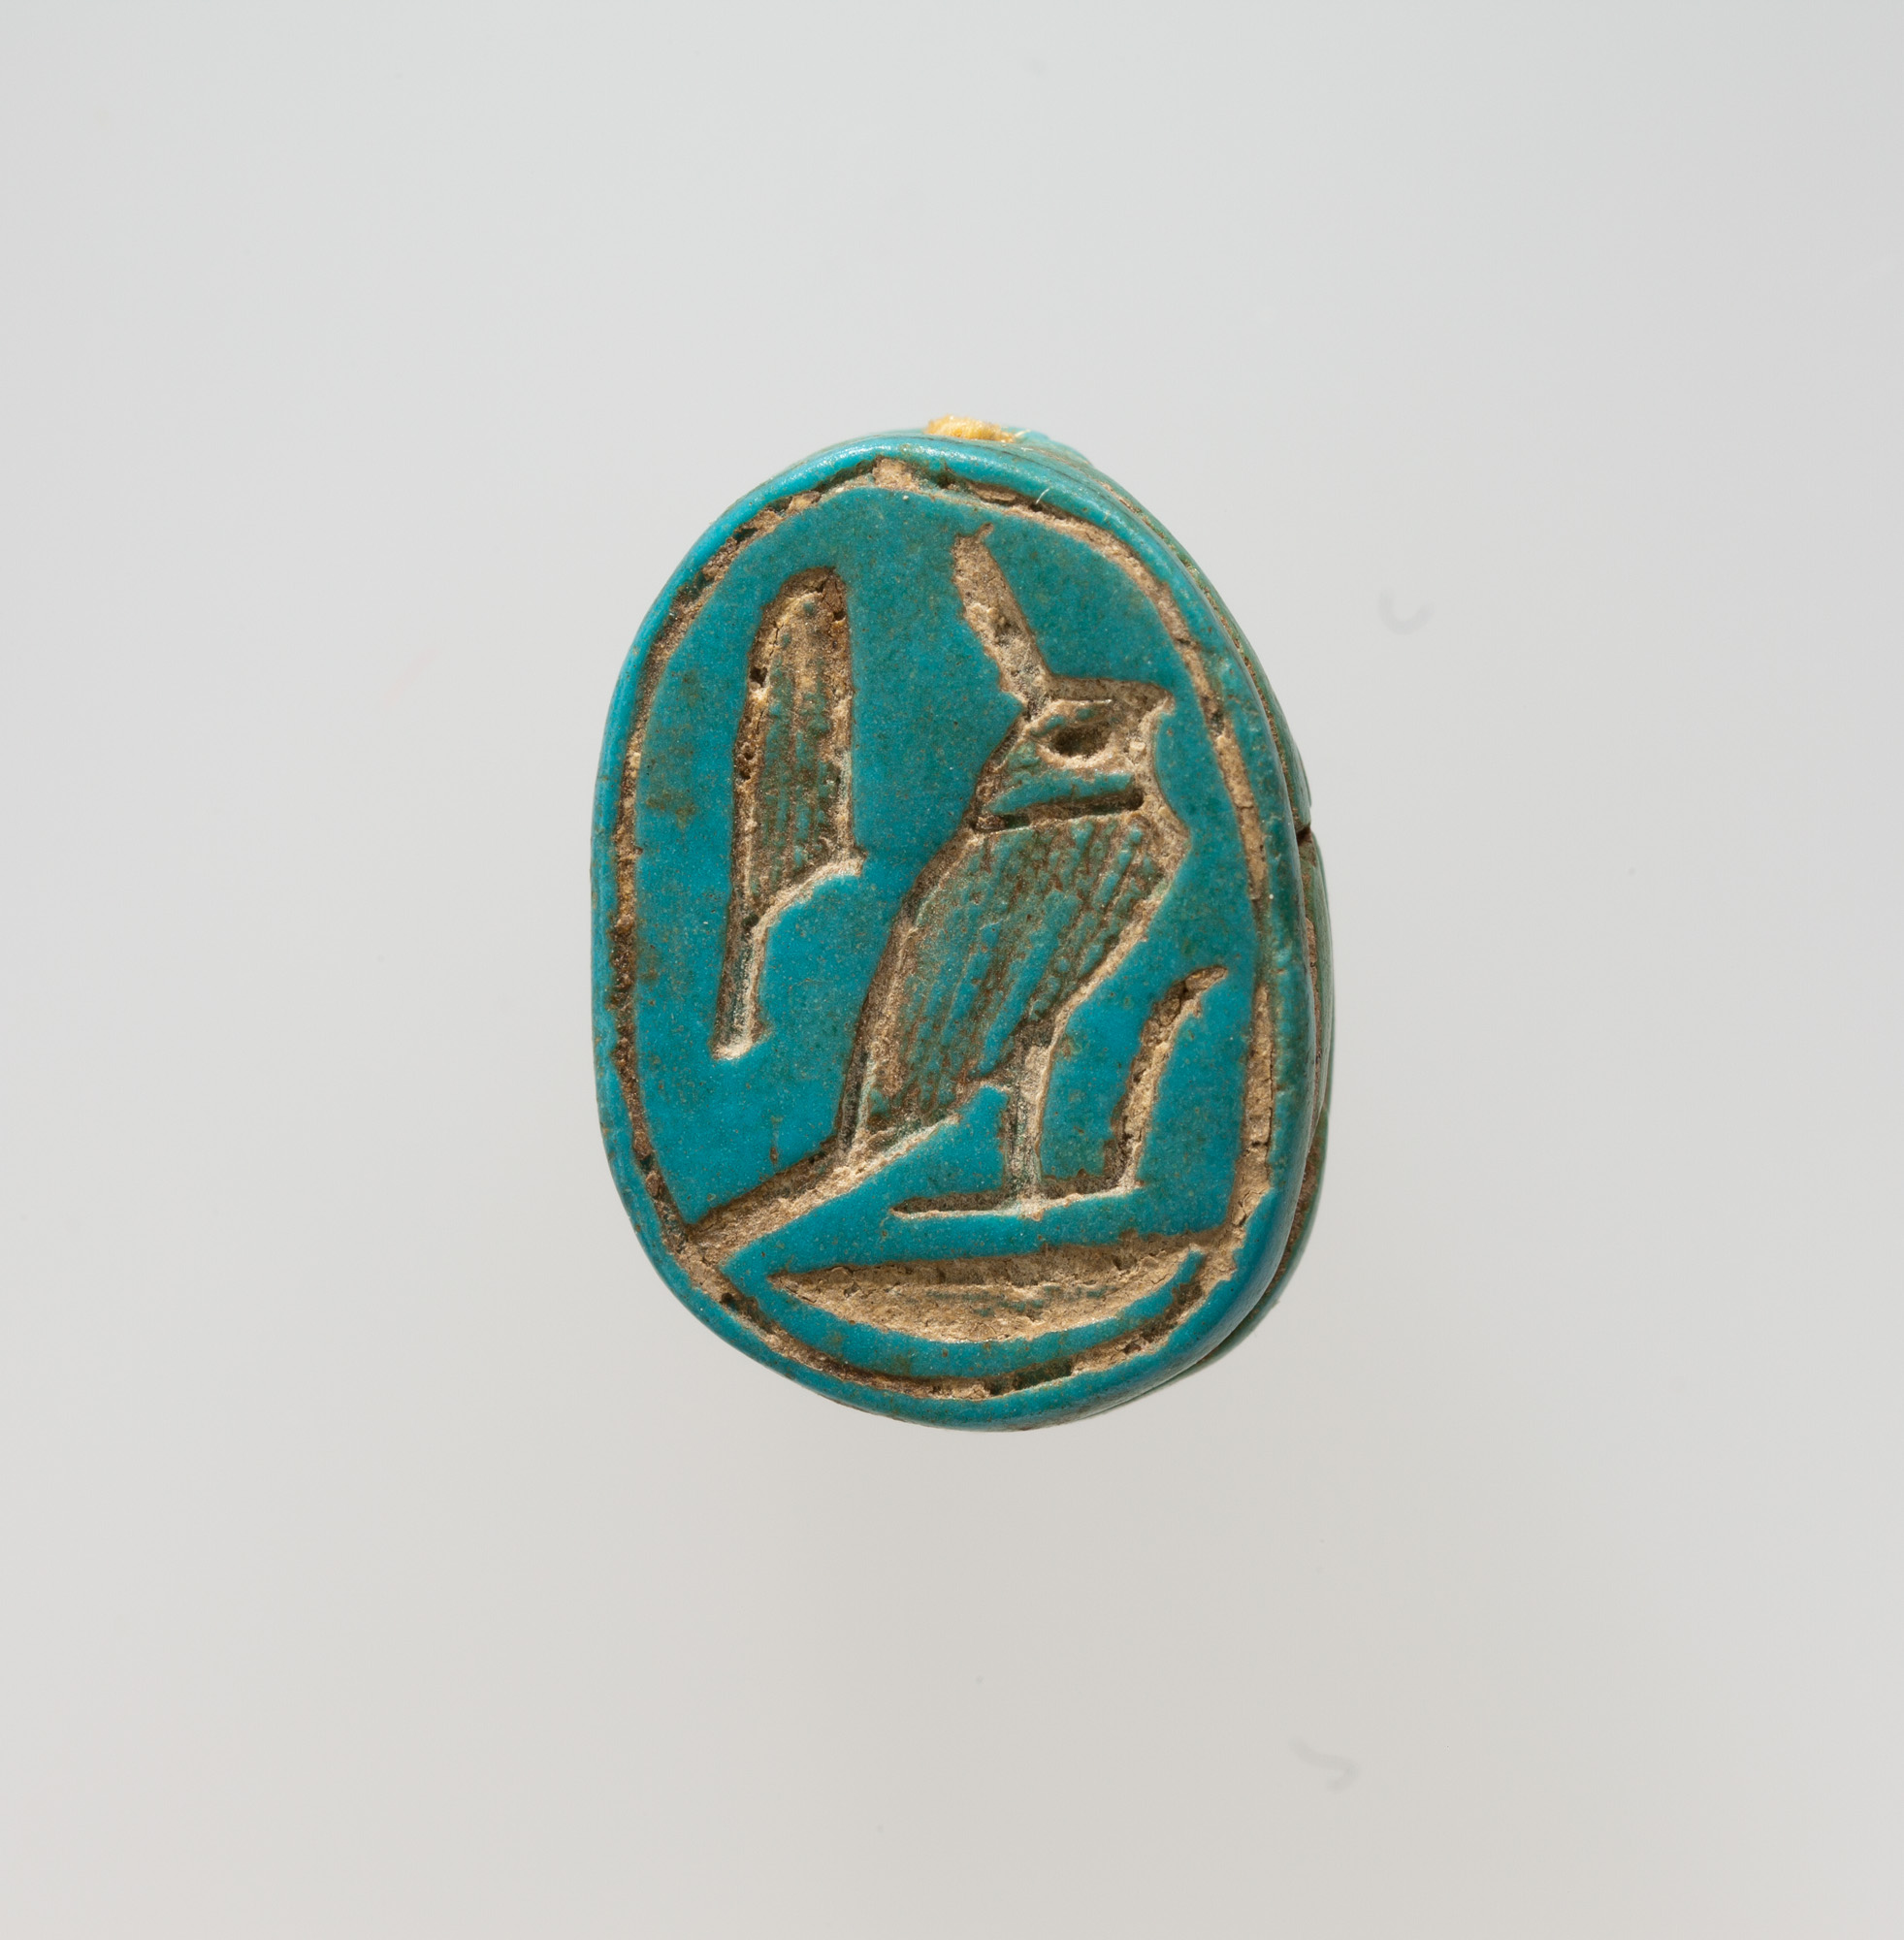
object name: scarab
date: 1479-1458 BCE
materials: stone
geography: egypt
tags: birds,scarabs